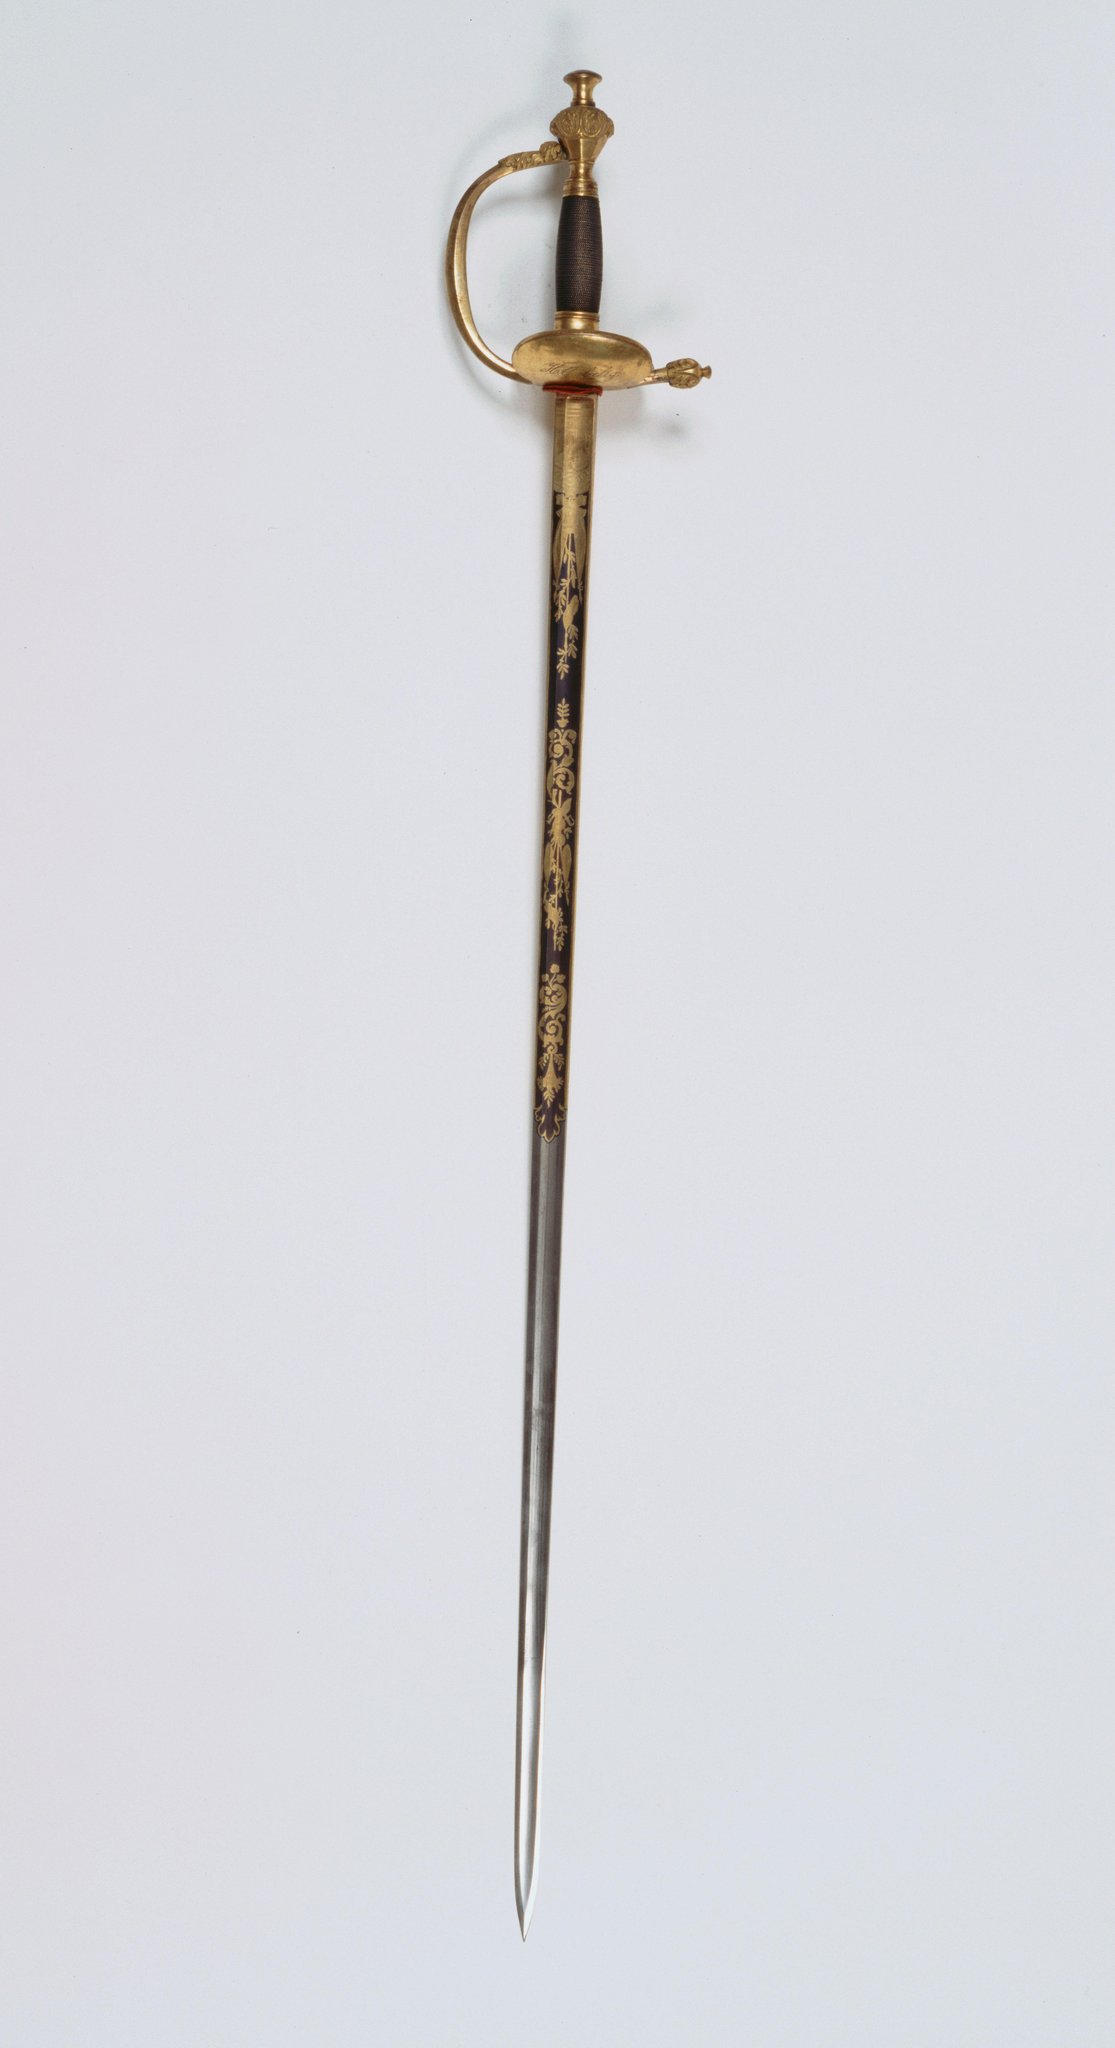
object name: sword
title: Officiersdegen algemeen model, 1820-1855, Koninkrijk der Nederlanden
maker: Anonymous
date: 1800-1855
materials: copper, glass, iron, wood, wool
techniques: amalgam gilded, cutting, engraving, etching, forging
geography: western europe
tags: neustadtgödens, ginneken, luitenant-generaal, hendrik gerard seelig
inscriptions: : ‘H.G. Seelig’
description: Degen met vuurverguld koperen gevest, bestaande uit knop met acanthusbladeren, voorbeugel idem geornamenteerd. Met zilverdraad omwikkelde greep. Twee, niet omklapbare stootplaten, gegraveerd: H.G. Seelig. Halve pareerstang met knop met acanthusbladeren. IJzeren met trofeëen en florale motieven versierde, geëtste, geblauwde en vuurvergulde kling. Tussen kling en stootplaat rood lakense stof. Zwart leren schede. Koperen vuurvergulde bovenband met draagknop. Schede met rood laken bekleed.